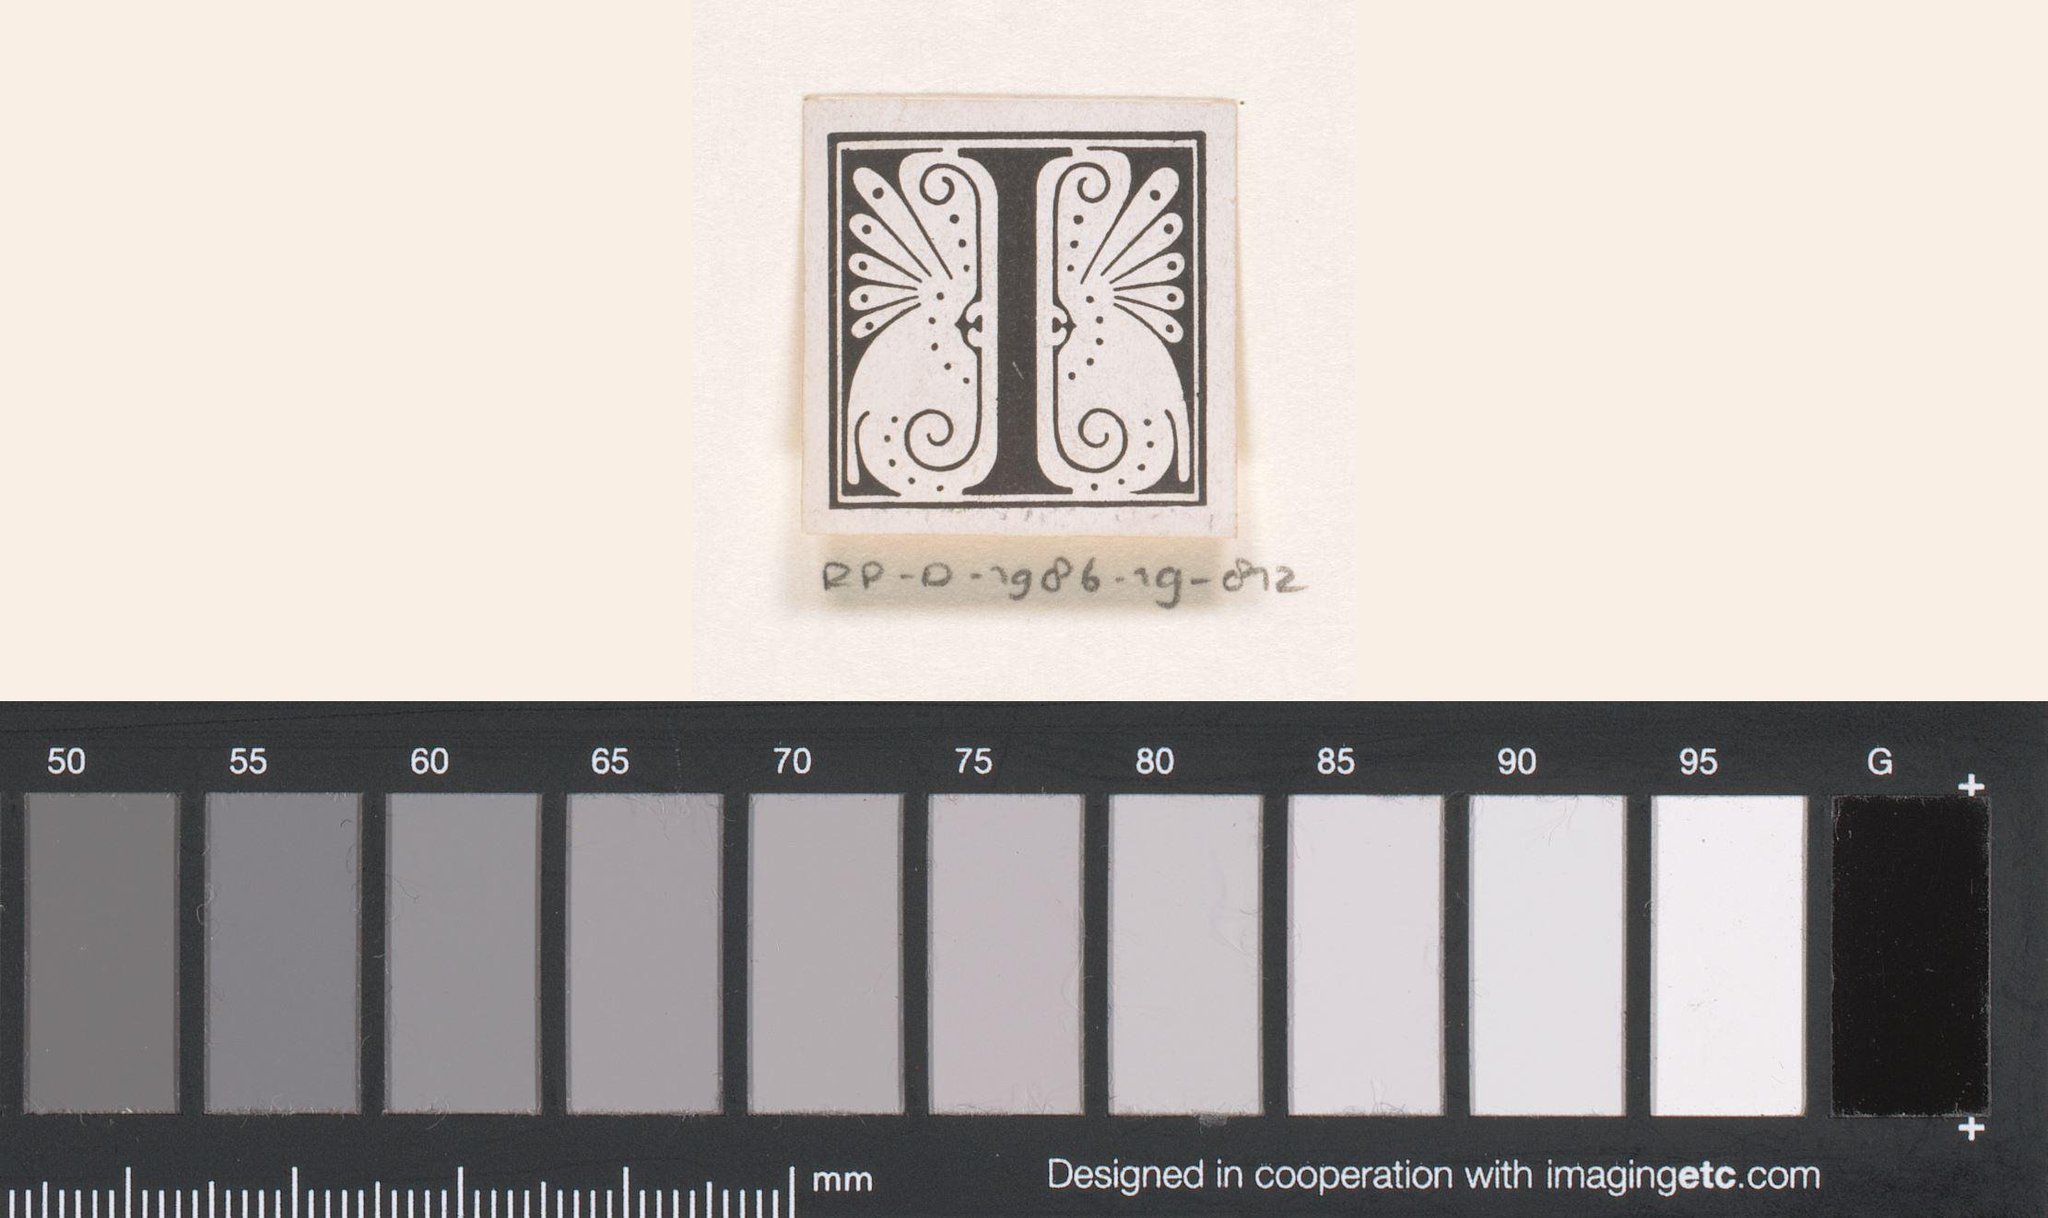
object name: photomechanical print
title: Initiaal I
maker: reinier willem petrus de vries (1874-1953)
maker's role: draughtsman, print maker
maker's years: 1874-1953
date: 1904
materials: paper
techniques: printing block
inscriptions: collector's mark: ‘R:MVS.’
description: Het initiaal is gebruikt voor: Veth, Jan. Jozef Israëls en zijn kunst. Arnhem en Nijmegen: Gebroeders E&M Cohen, 1904.